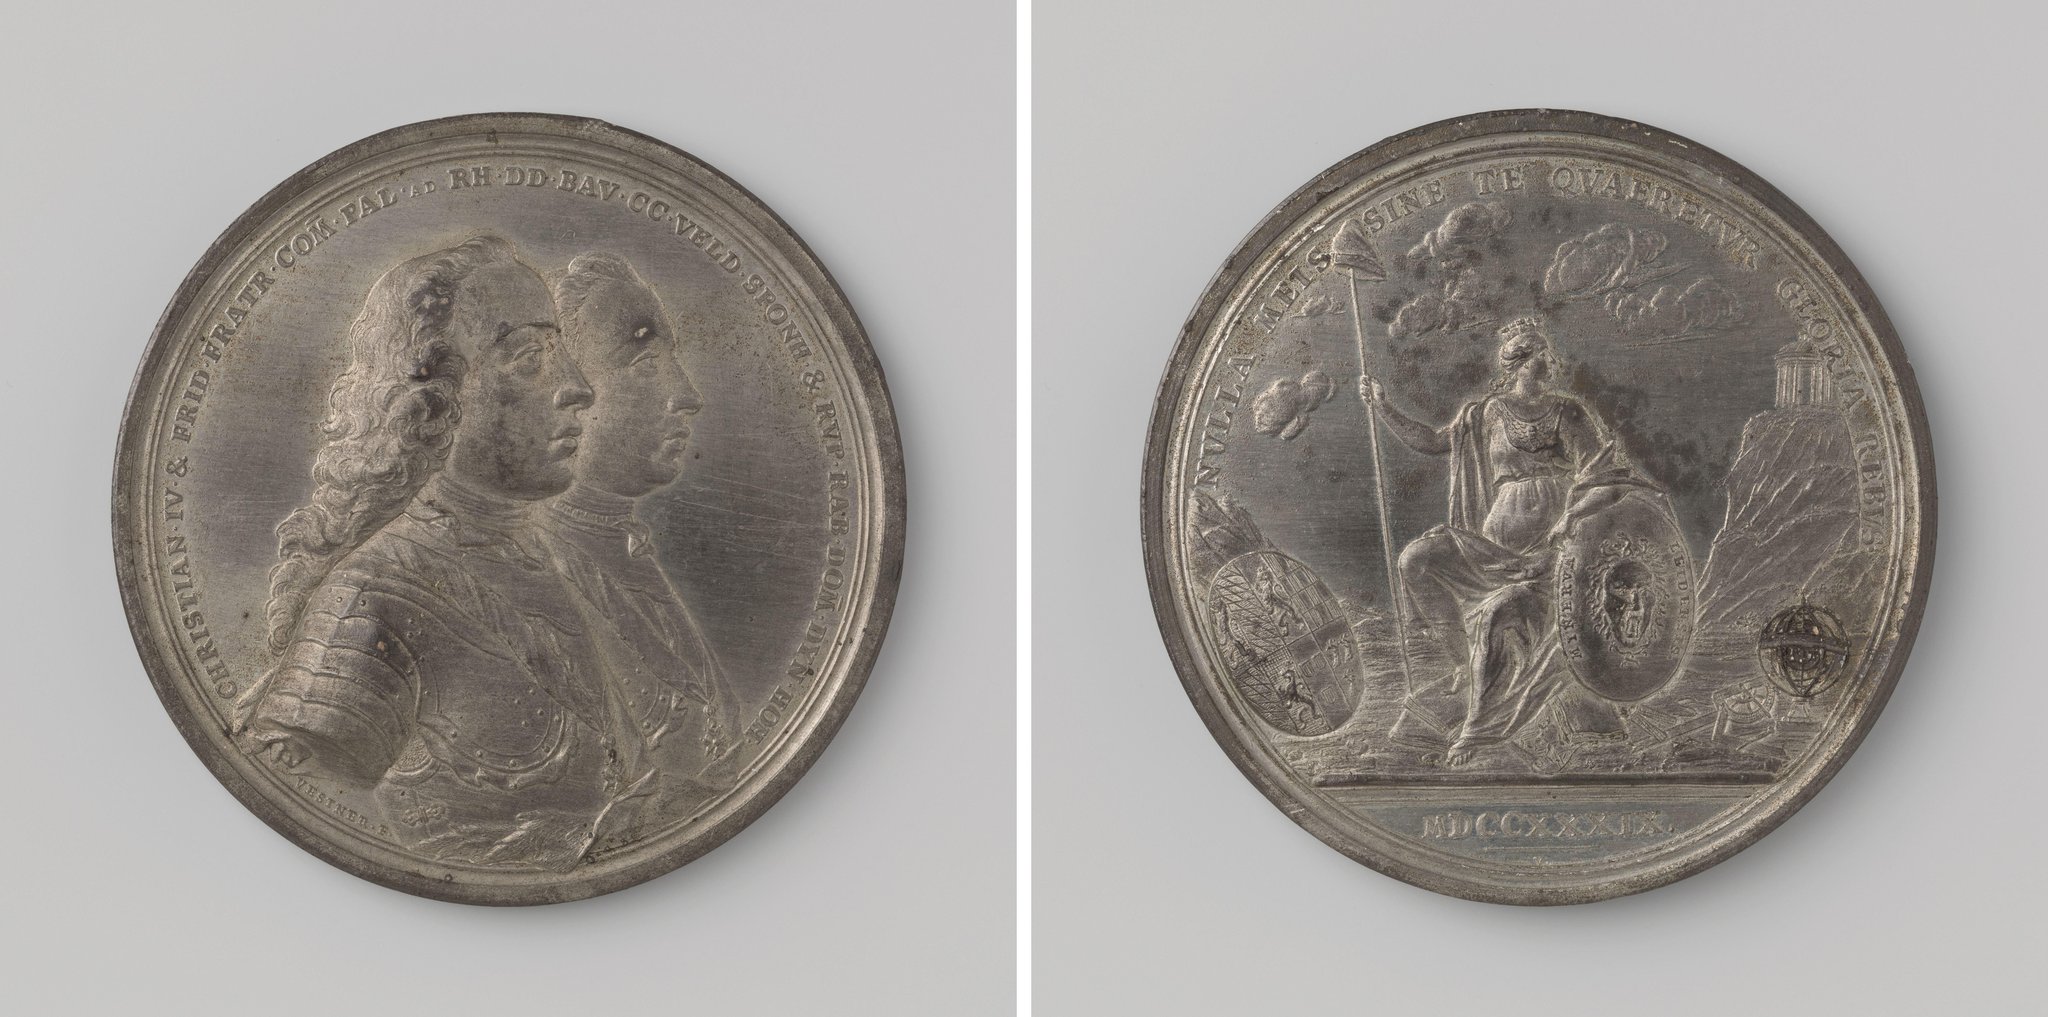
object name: history medal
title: Christiaan IV en Frederik, paltsgraven van de Rijn, hertogen van Beieren verlaten de Hogeschool te Leiden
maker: georg wilhelm vestner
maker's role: medailleur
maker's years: 1677-1740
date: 1739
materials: lead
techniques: engraving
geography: nuremberg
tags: christiaan iv (hertog van palts-tweebruggen), leiden